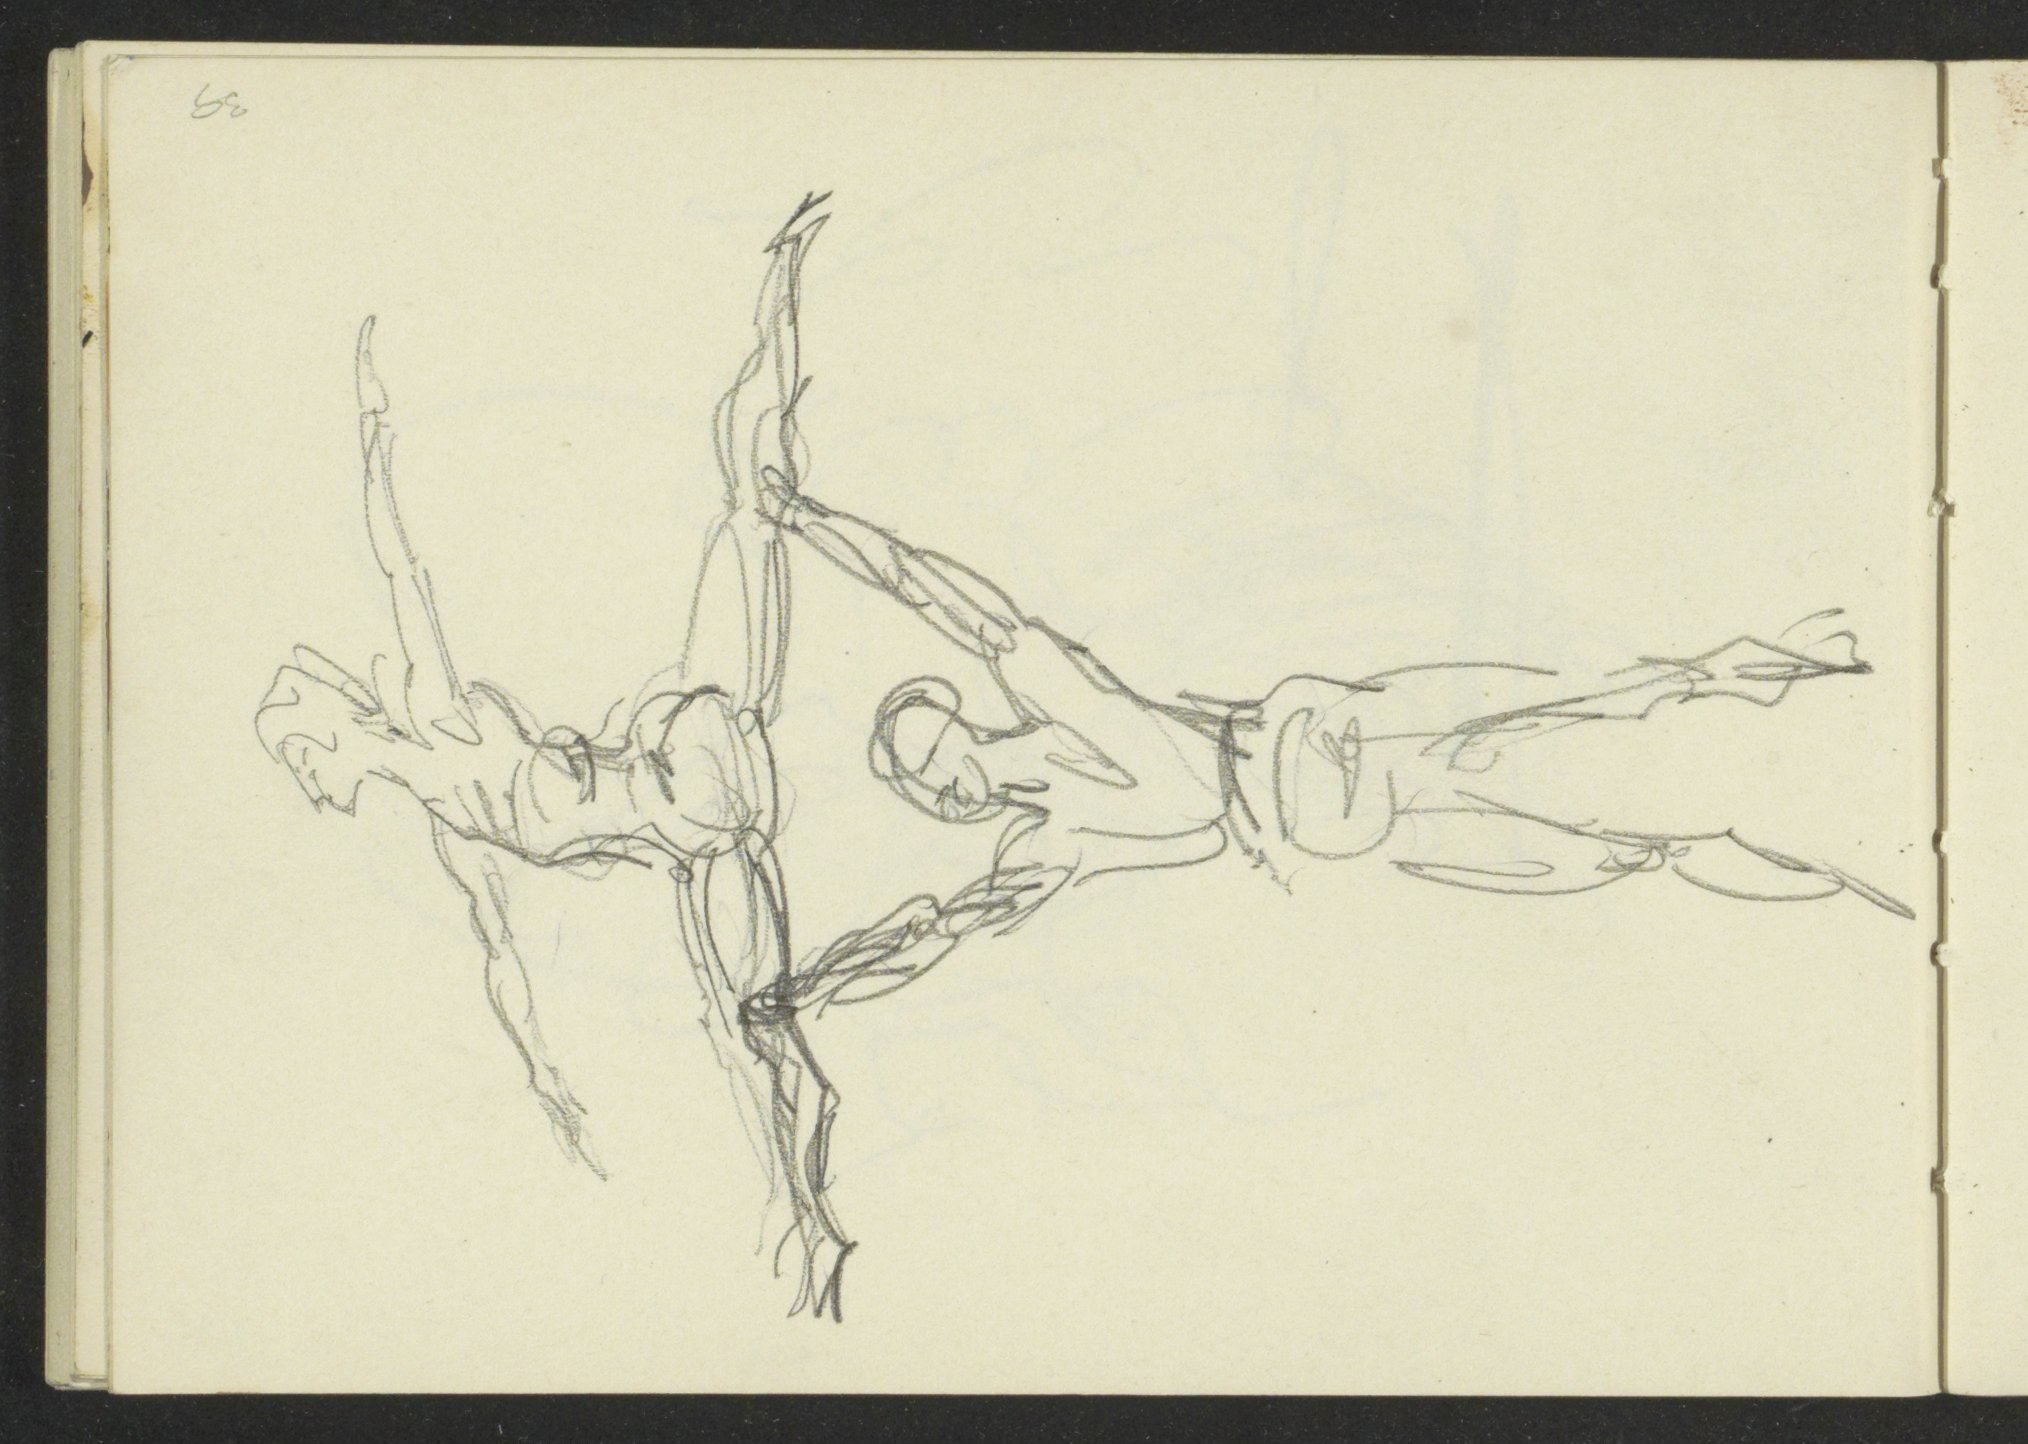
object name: sketchbook leaf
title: Twee acrobaten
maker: isaac israels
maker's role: draughtsman, painter, print maker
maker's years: 1865-1934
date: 1875-1934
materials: paper, pencil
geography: the hague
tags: acrobat ~ circus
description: Een acrobaat tilt een andere acrobaat in spagaat boven zijn hoofd. Blad 20 verso uit schetsboek LVII met 29 bladen.